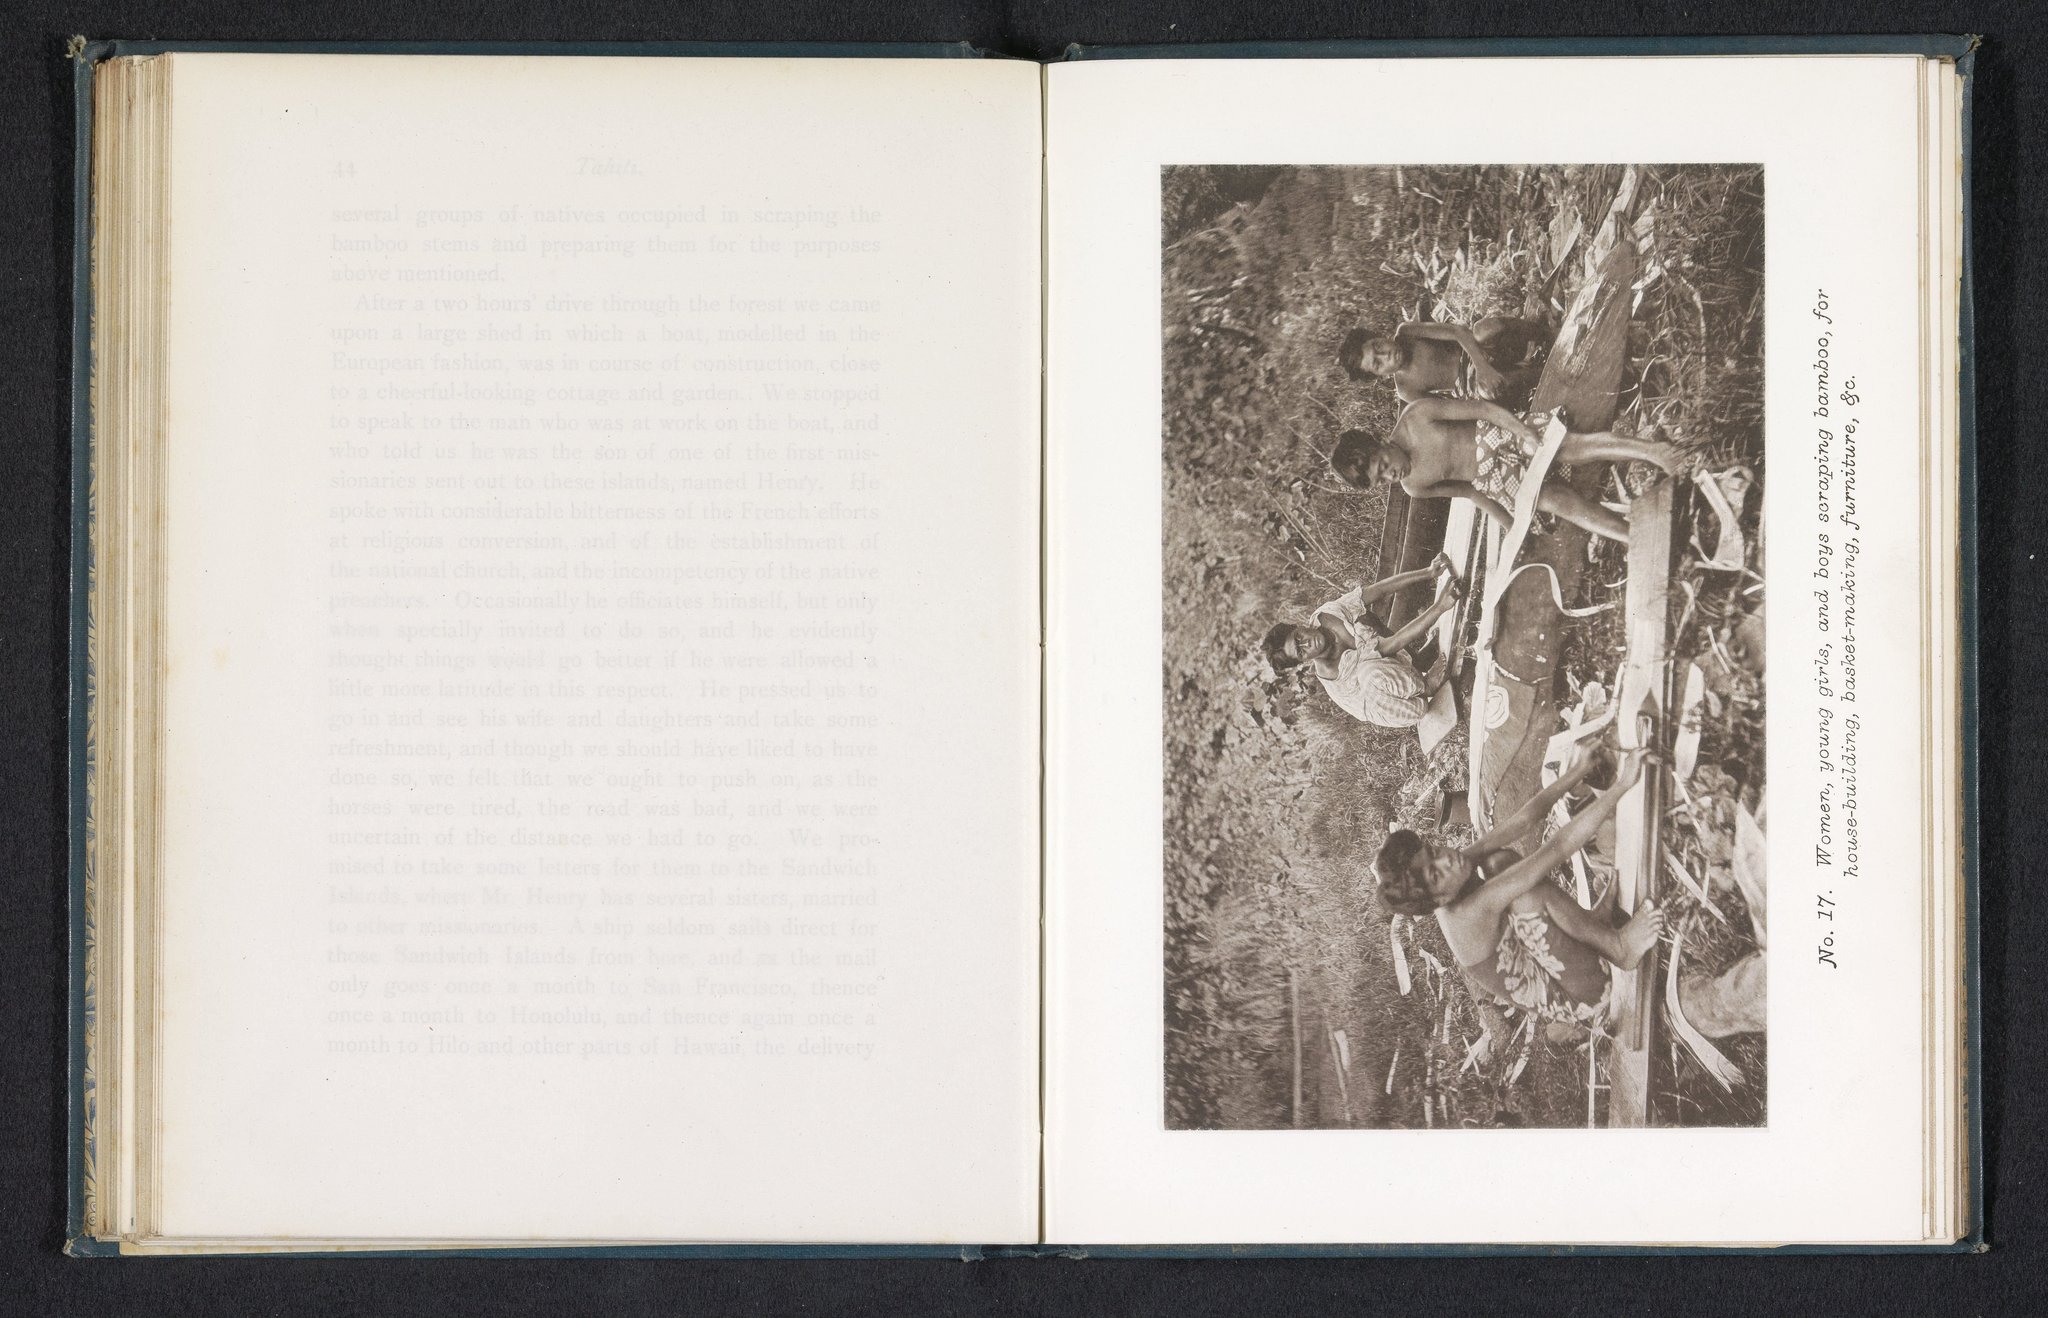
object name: page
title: Mensen die bamboe bewerken op Tahiti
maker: henry stuart-wortley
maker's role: fotograaf, kolonel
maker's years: 1832-1890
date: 1880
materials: paper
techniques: photograph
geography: tahiti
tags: other handicrafts ~ wood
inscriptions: number: ‘No. 17.’